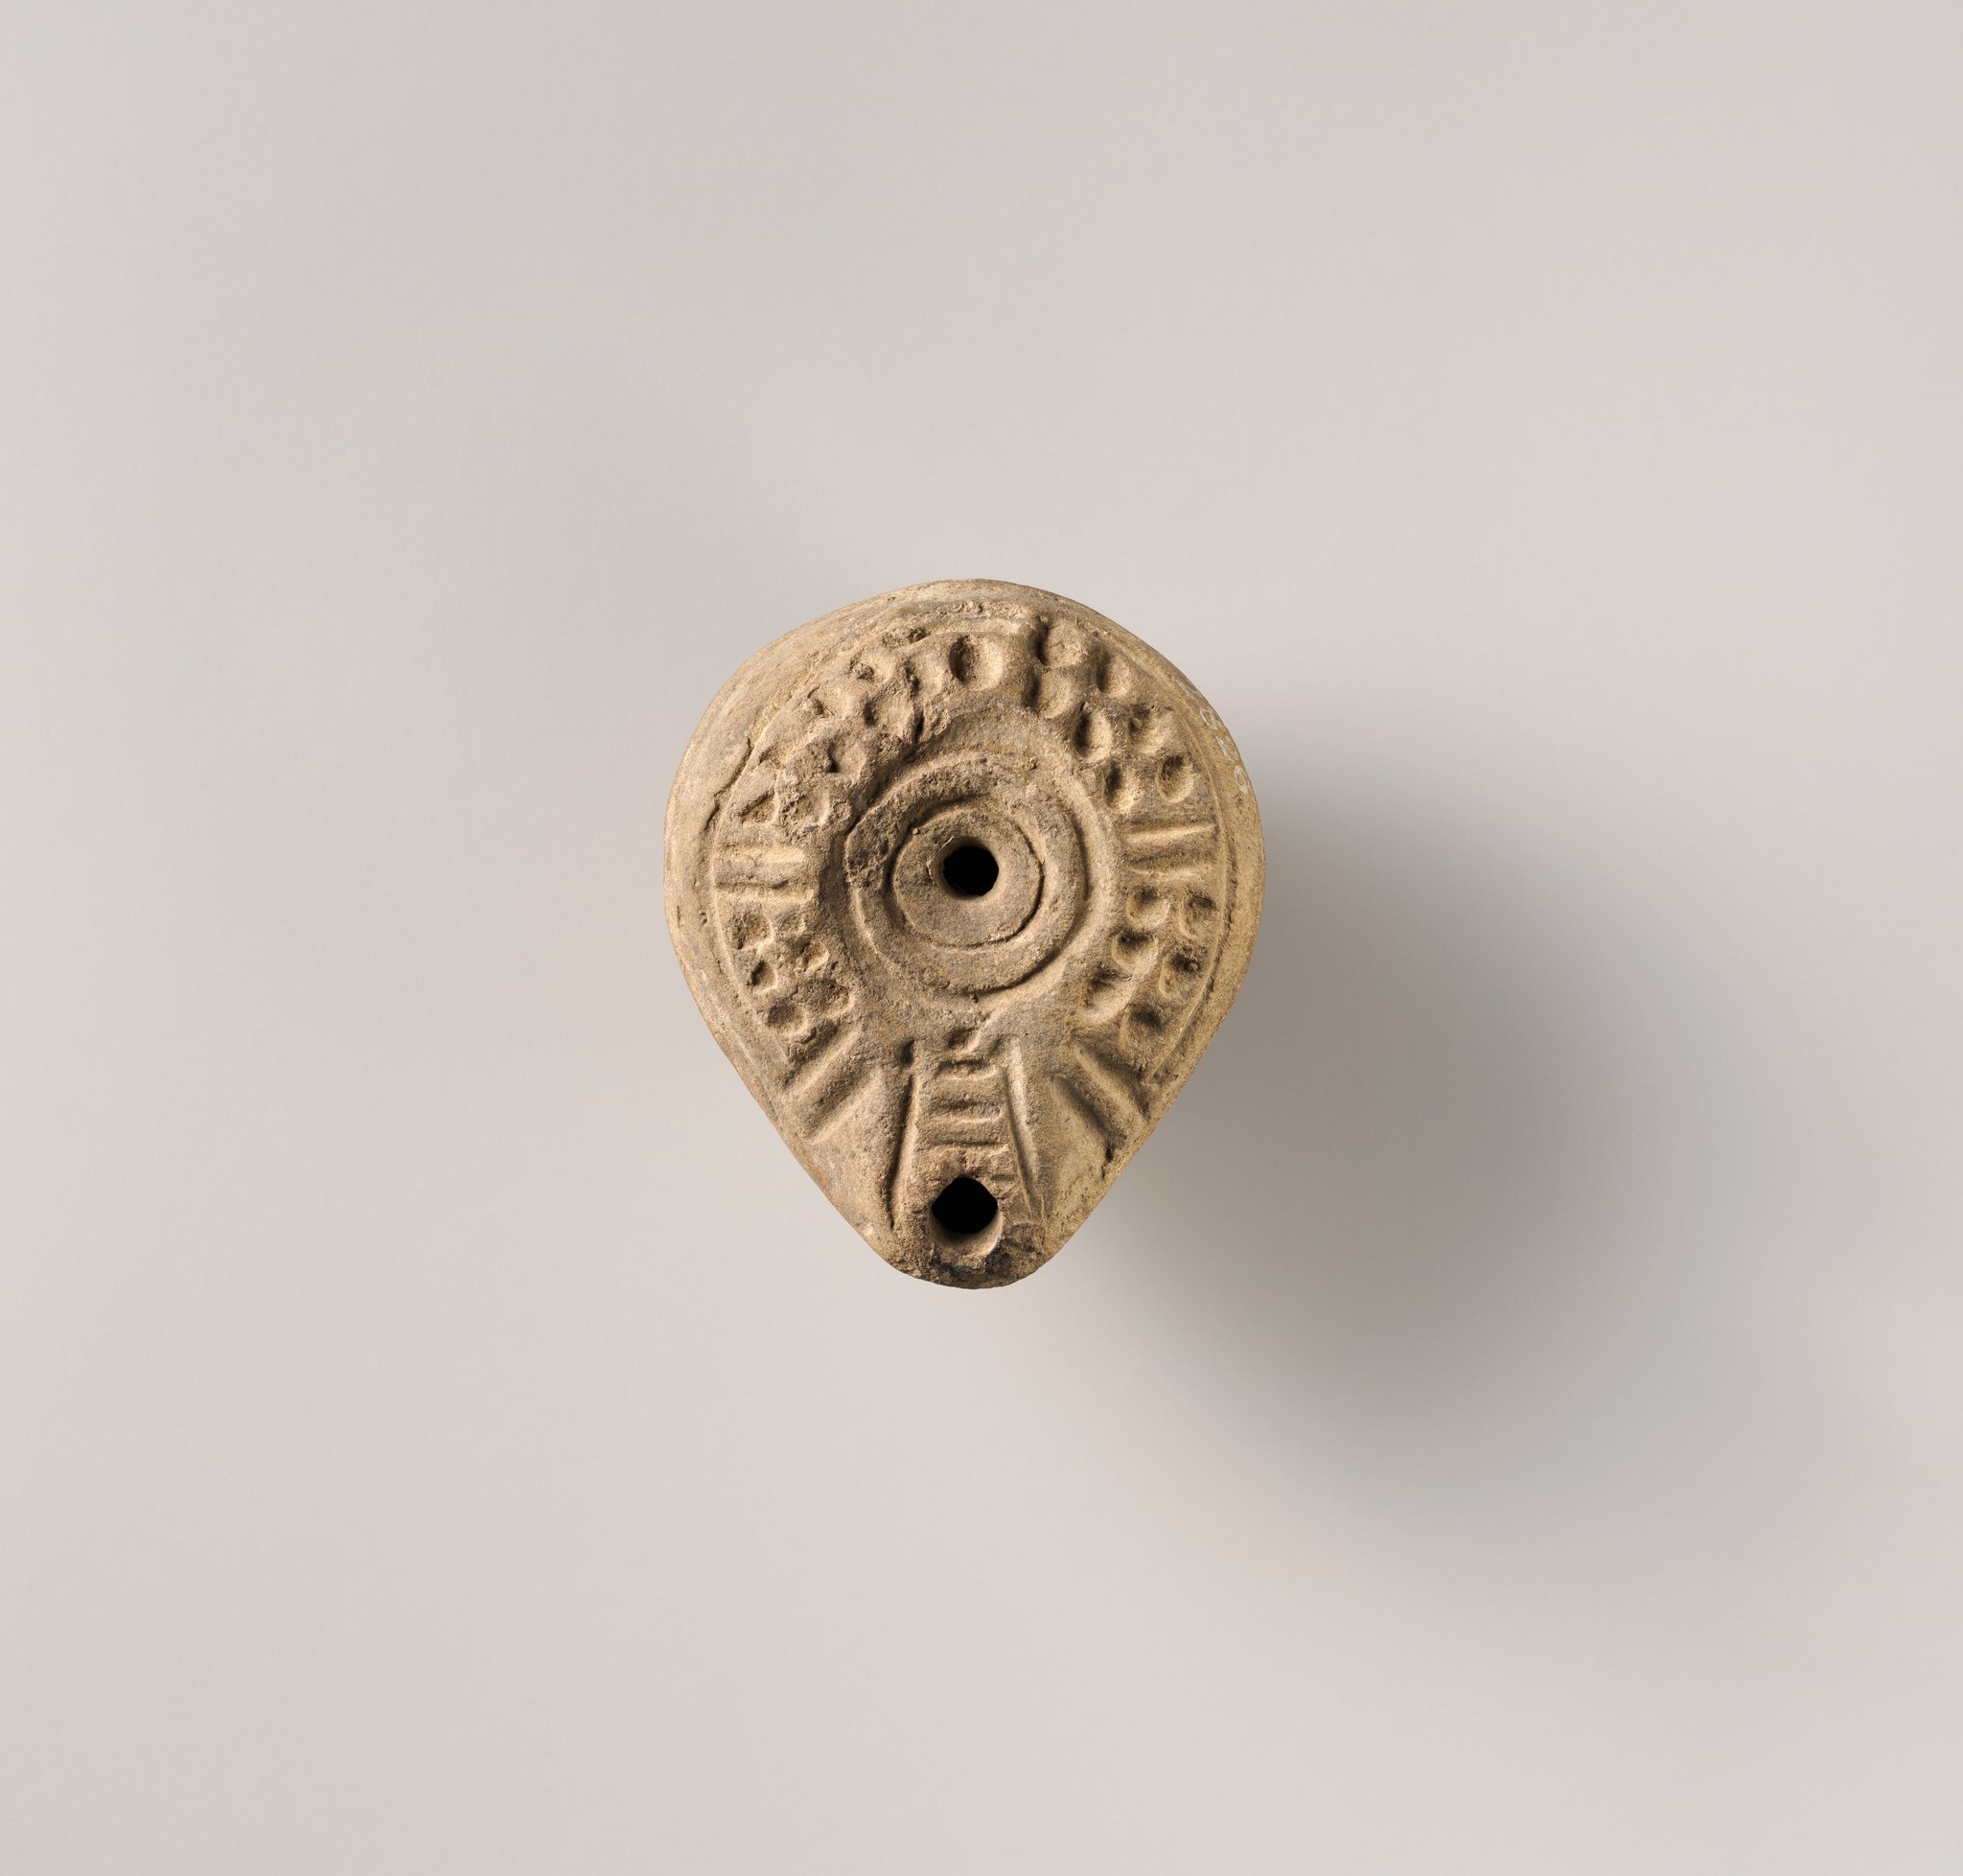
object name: lamp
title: Terracotta oil lamp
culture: roman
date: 267-300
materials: terracotta